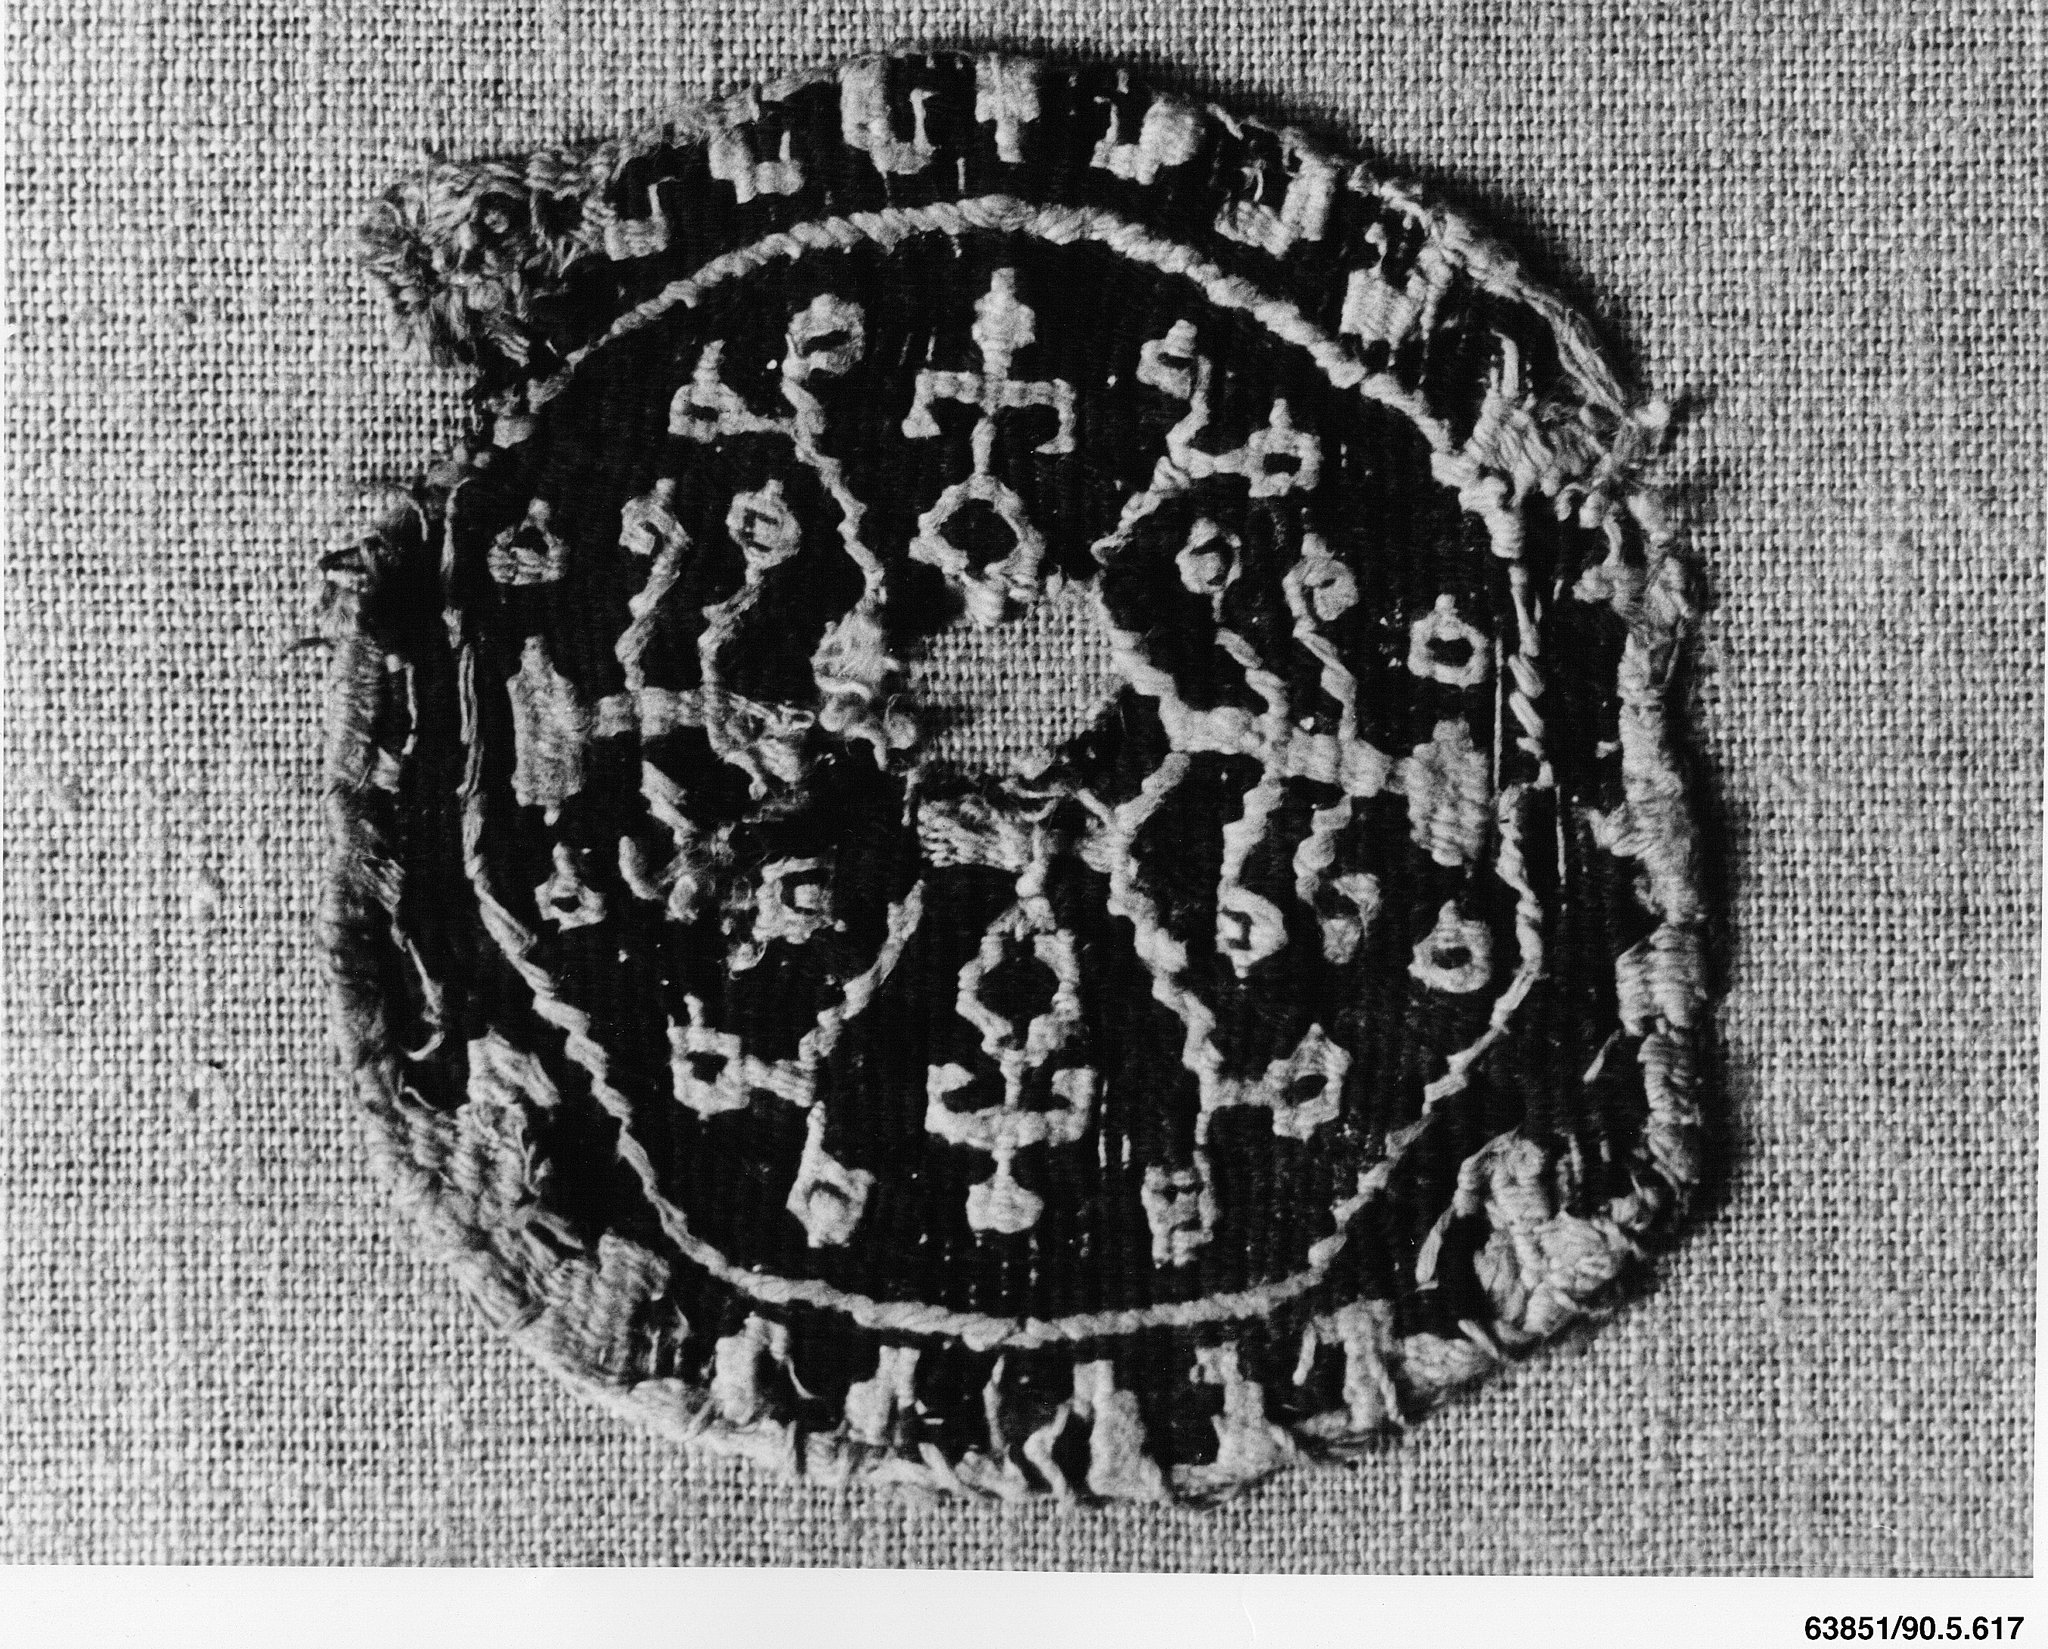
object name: textile fragment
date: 301-400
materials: linen, wool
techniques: weave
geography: egypt